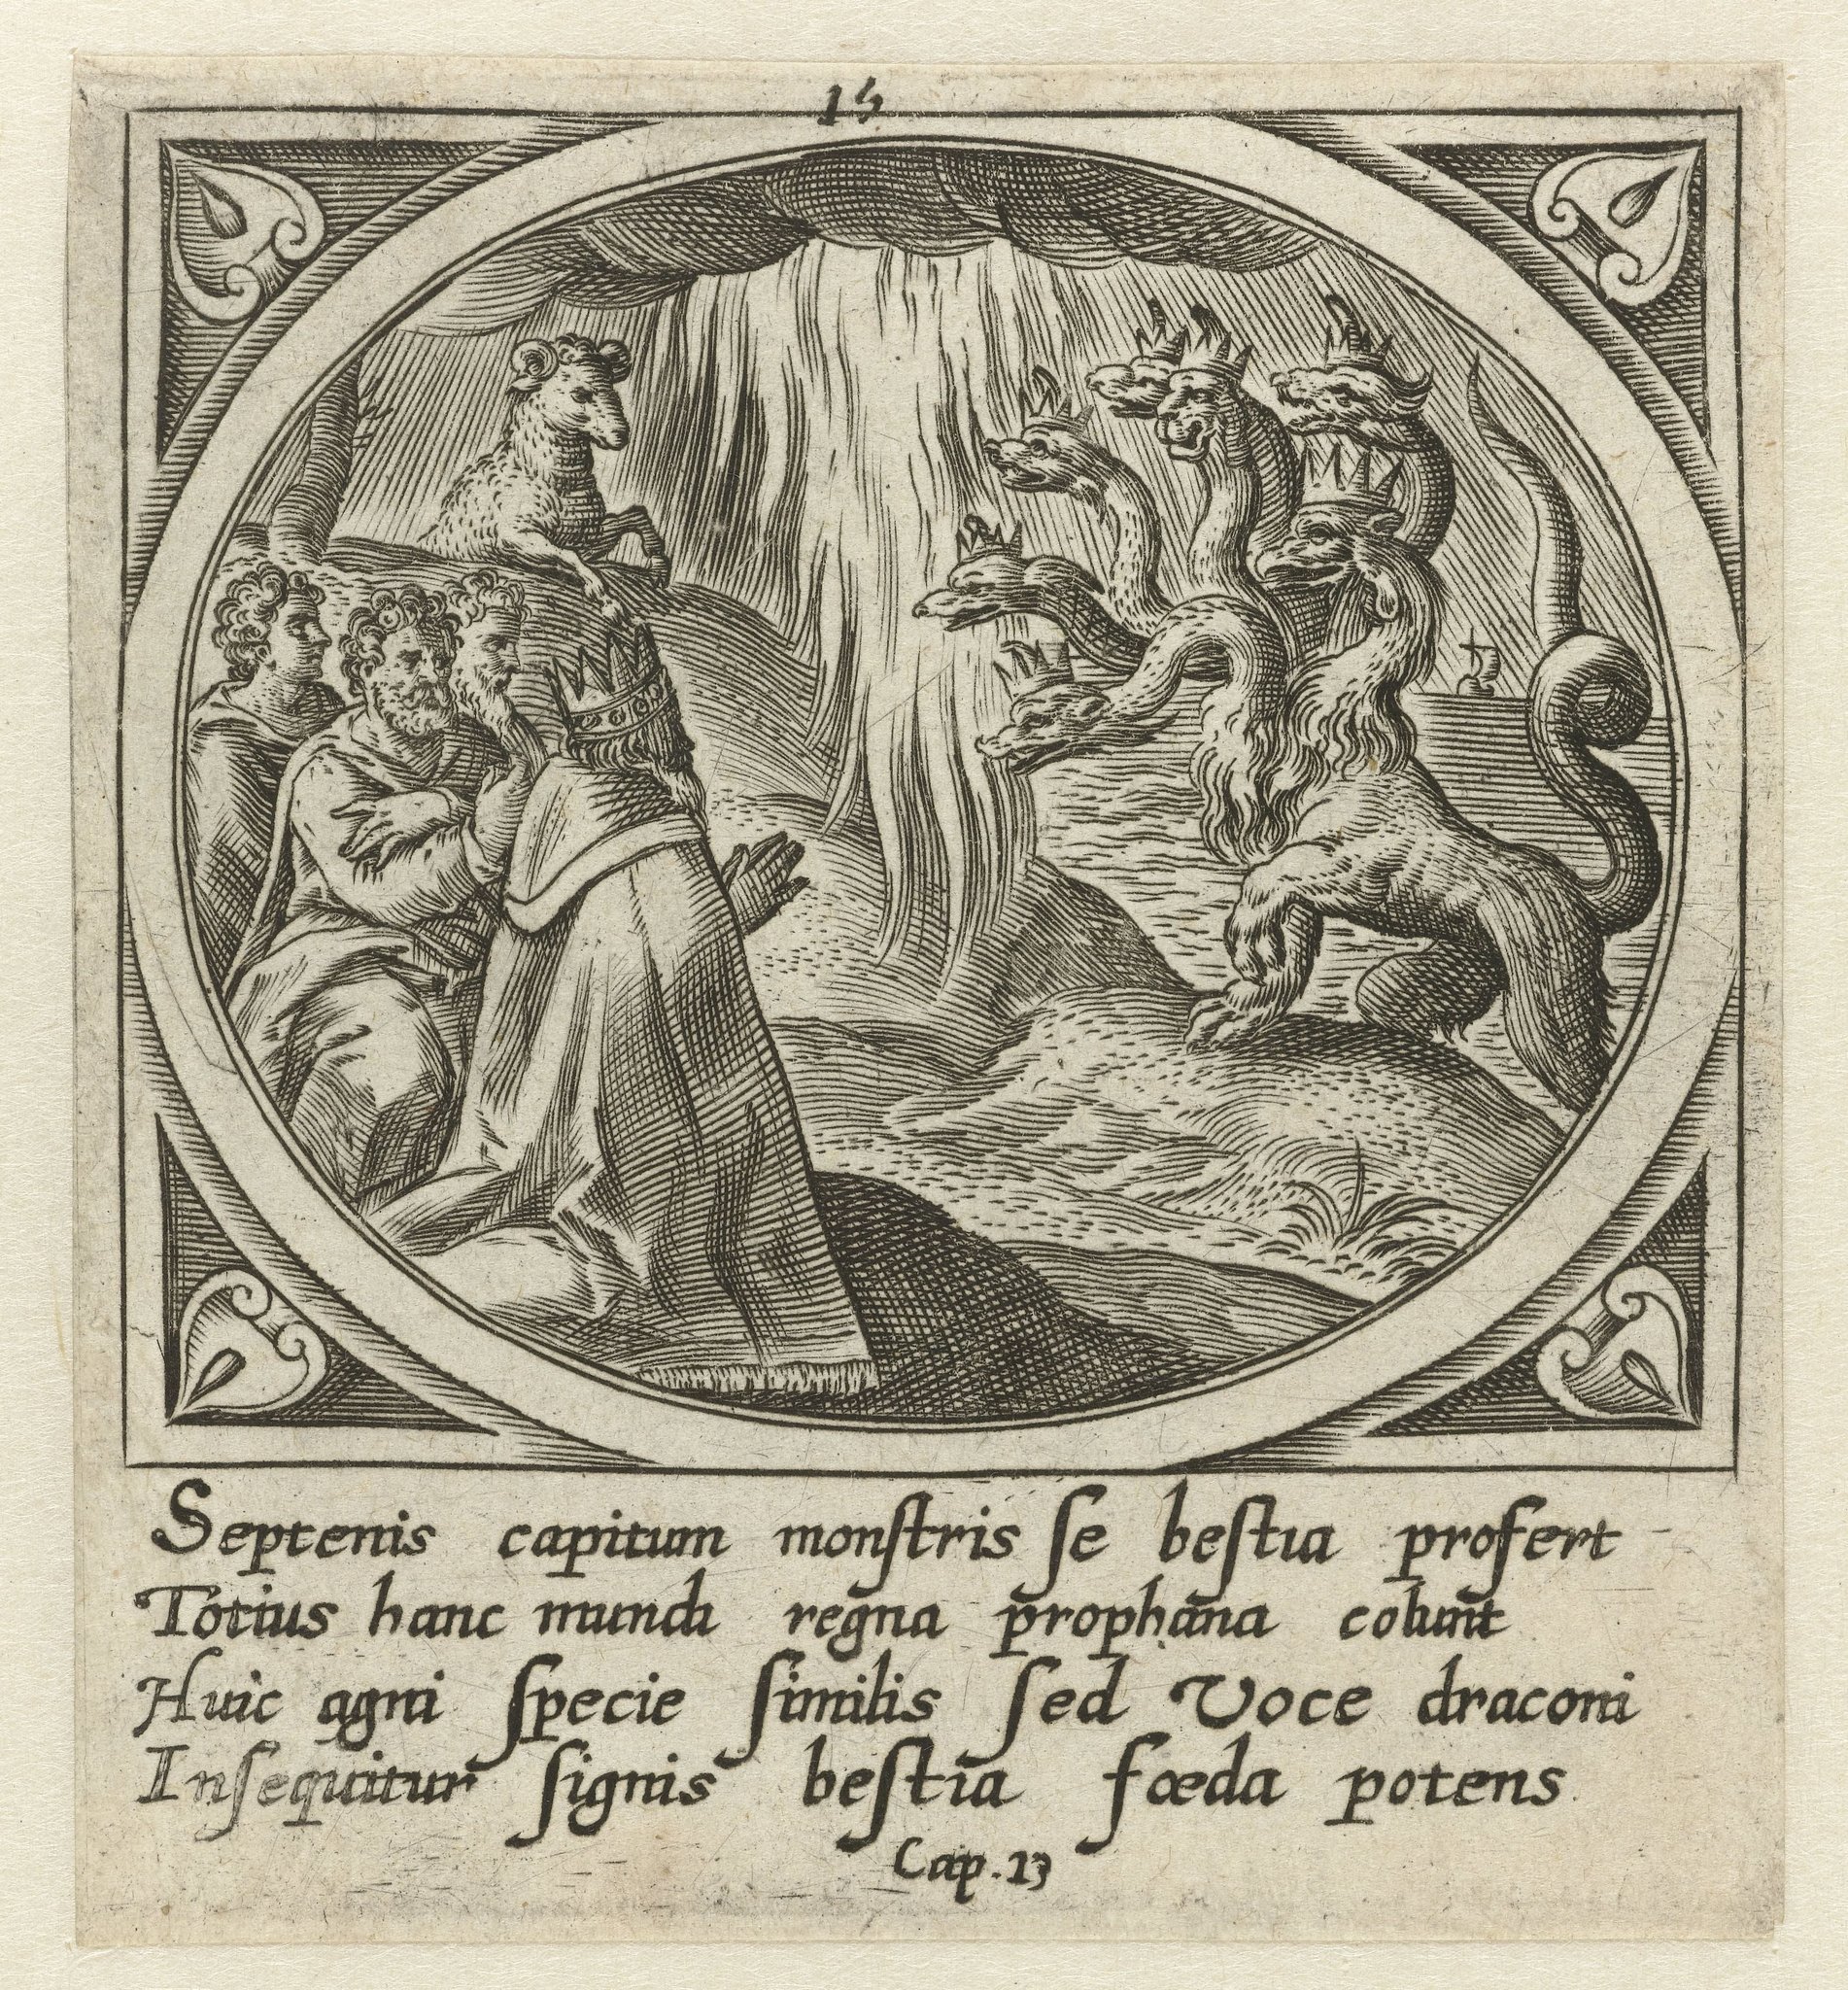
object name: print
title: Icones Revelationum S Johs Evangeliste in Pathmo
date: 1585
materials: paper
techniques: engraving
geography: antwerp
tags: the leopard-like beast with seven heads comes out of the sea and is worshipped together with the dragon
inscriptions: collector's mark: Lugt 2228, collector's mark: Lugt 2760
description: Uit de zee komt het zevenkoppige gekroonde beest dat door de mensen wordt vereerd. Van achter een berg verschijnt het tweede beest in de gedaante van een ram. In de marge een vierregelig onderschrift in het Latijn. Vijftiende prent uit een serie van vierentwintig met de openbaring van Johannes op Patmos.